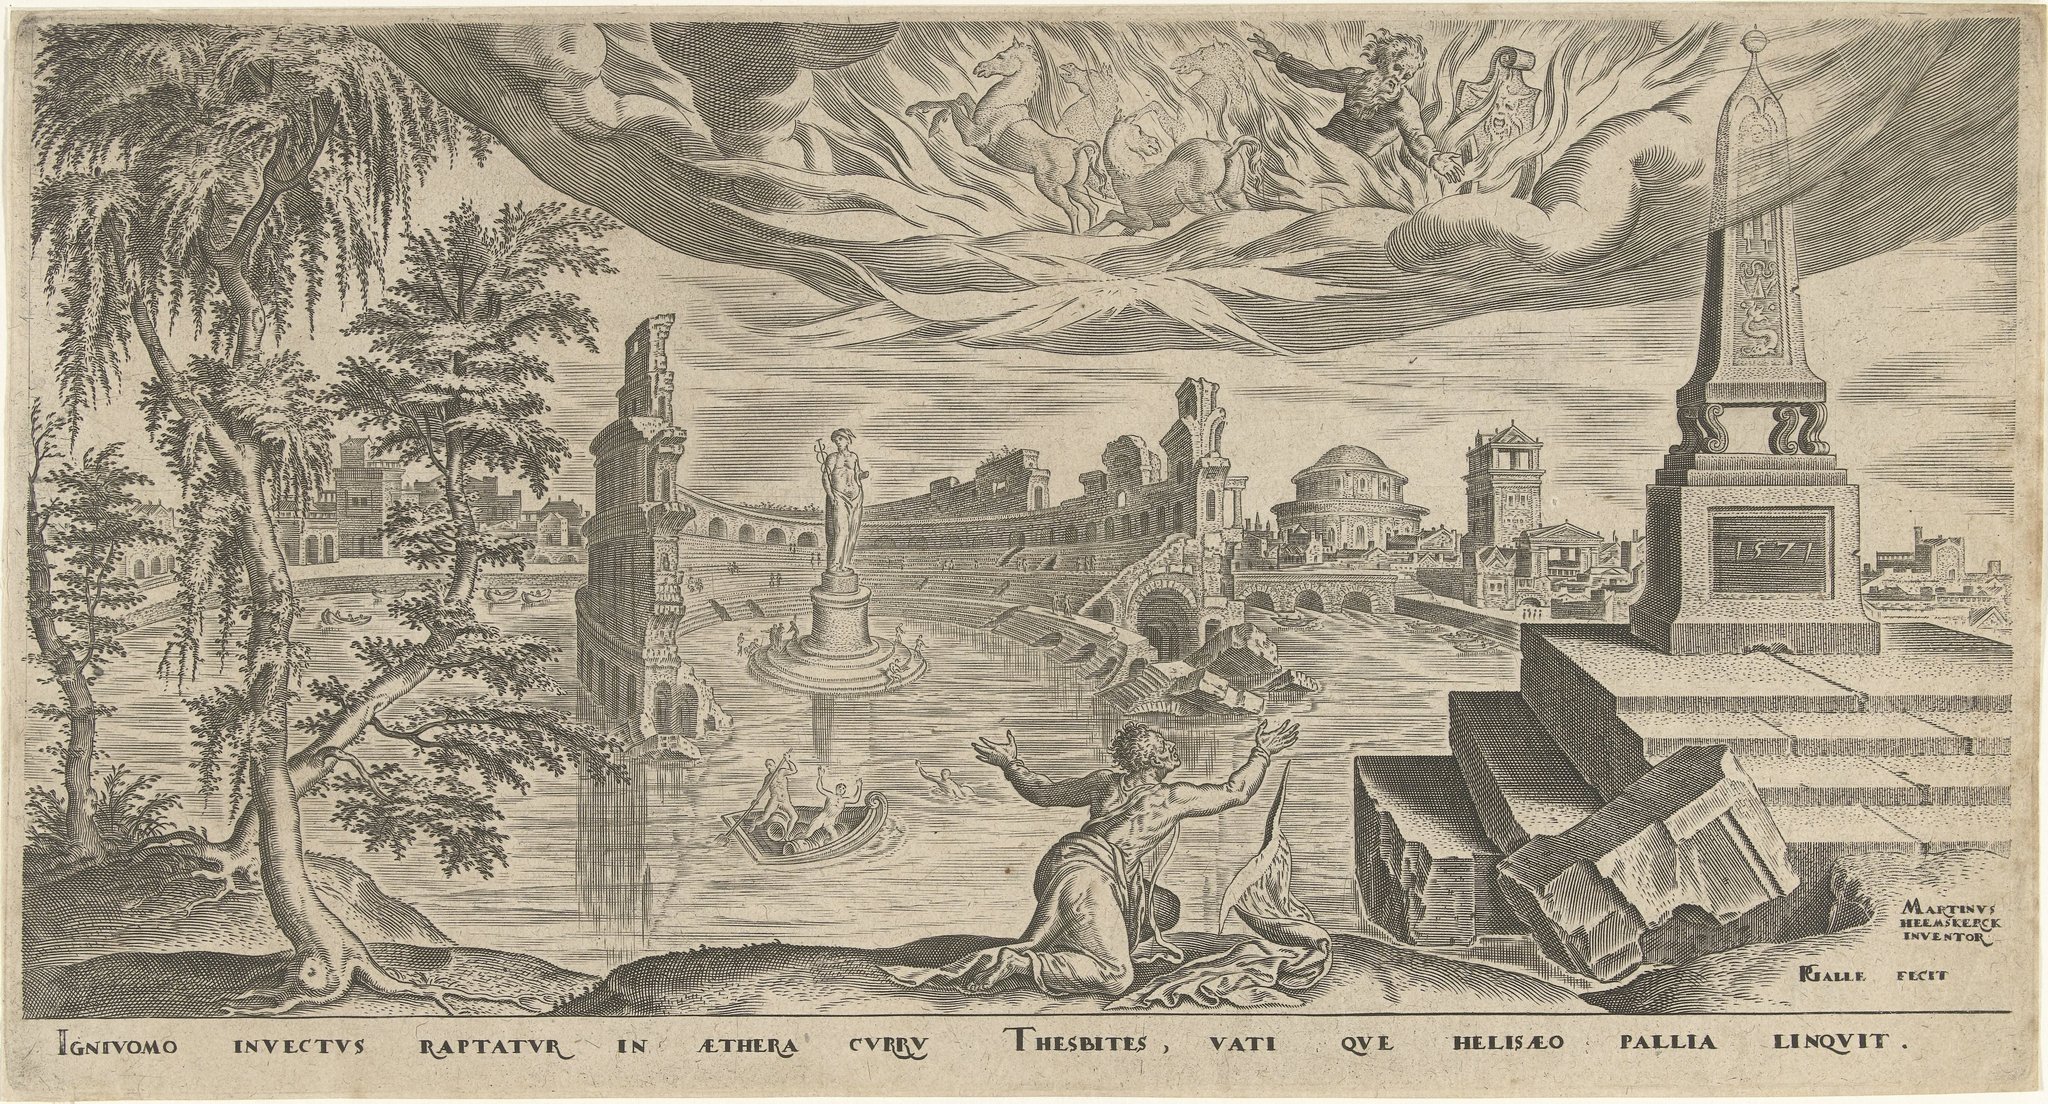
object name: print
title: Landschap met Elisa, die de mantel van Elia ontvangt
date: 1571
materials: paper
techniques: engraving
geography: antwerp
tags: elisha picks up elijah's cloak and goes back to the jordan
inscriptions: collector's mark: Lugt 11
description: Elia zit in een wagen van vuur die getrokken wordt door vier paarden en die naar de hemel rijdt. Elisa knielt op de grond, de mantel van Elia naast zich. Op de achtergrond een door overstroming geteisterde stad.